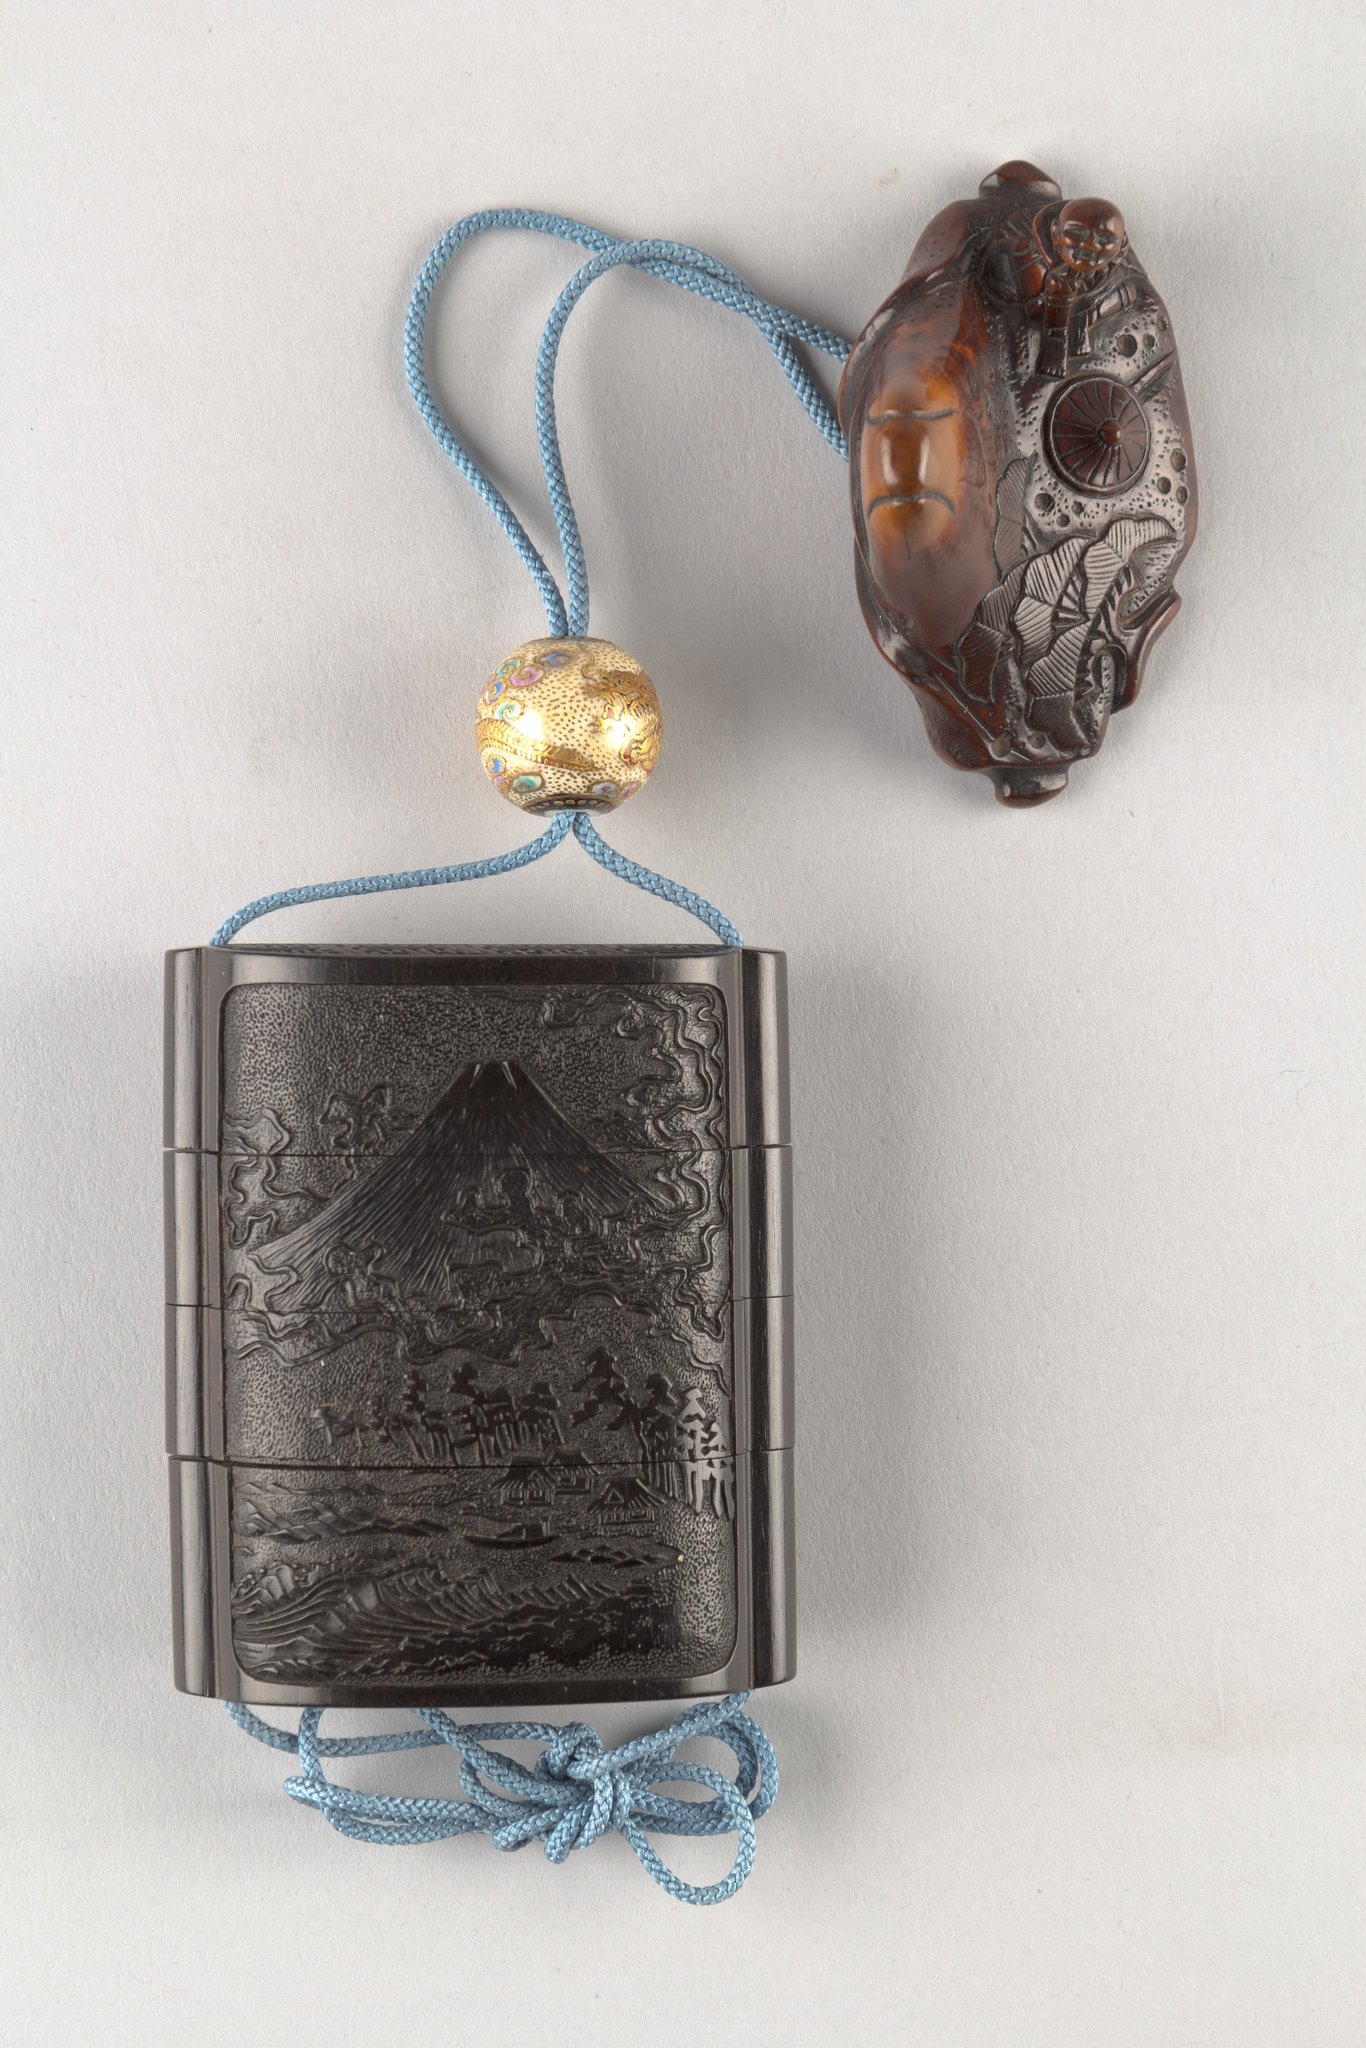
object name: inrō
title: Case (Inrō) with Design of Mount Fuji (obverse); Dragon in Clouds and Waves (reverse)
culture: japanese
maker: gantai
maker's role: artist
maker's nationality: japanese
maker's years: 1782-1865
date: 1801-1900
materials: lacquer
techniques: carving, incising, relief, roiro